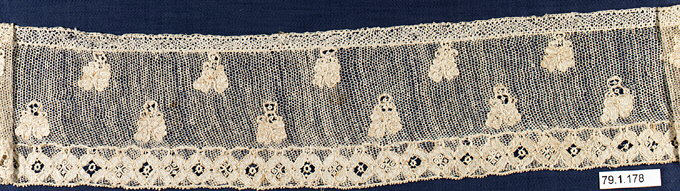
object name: strip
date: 1767-1800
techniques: lace